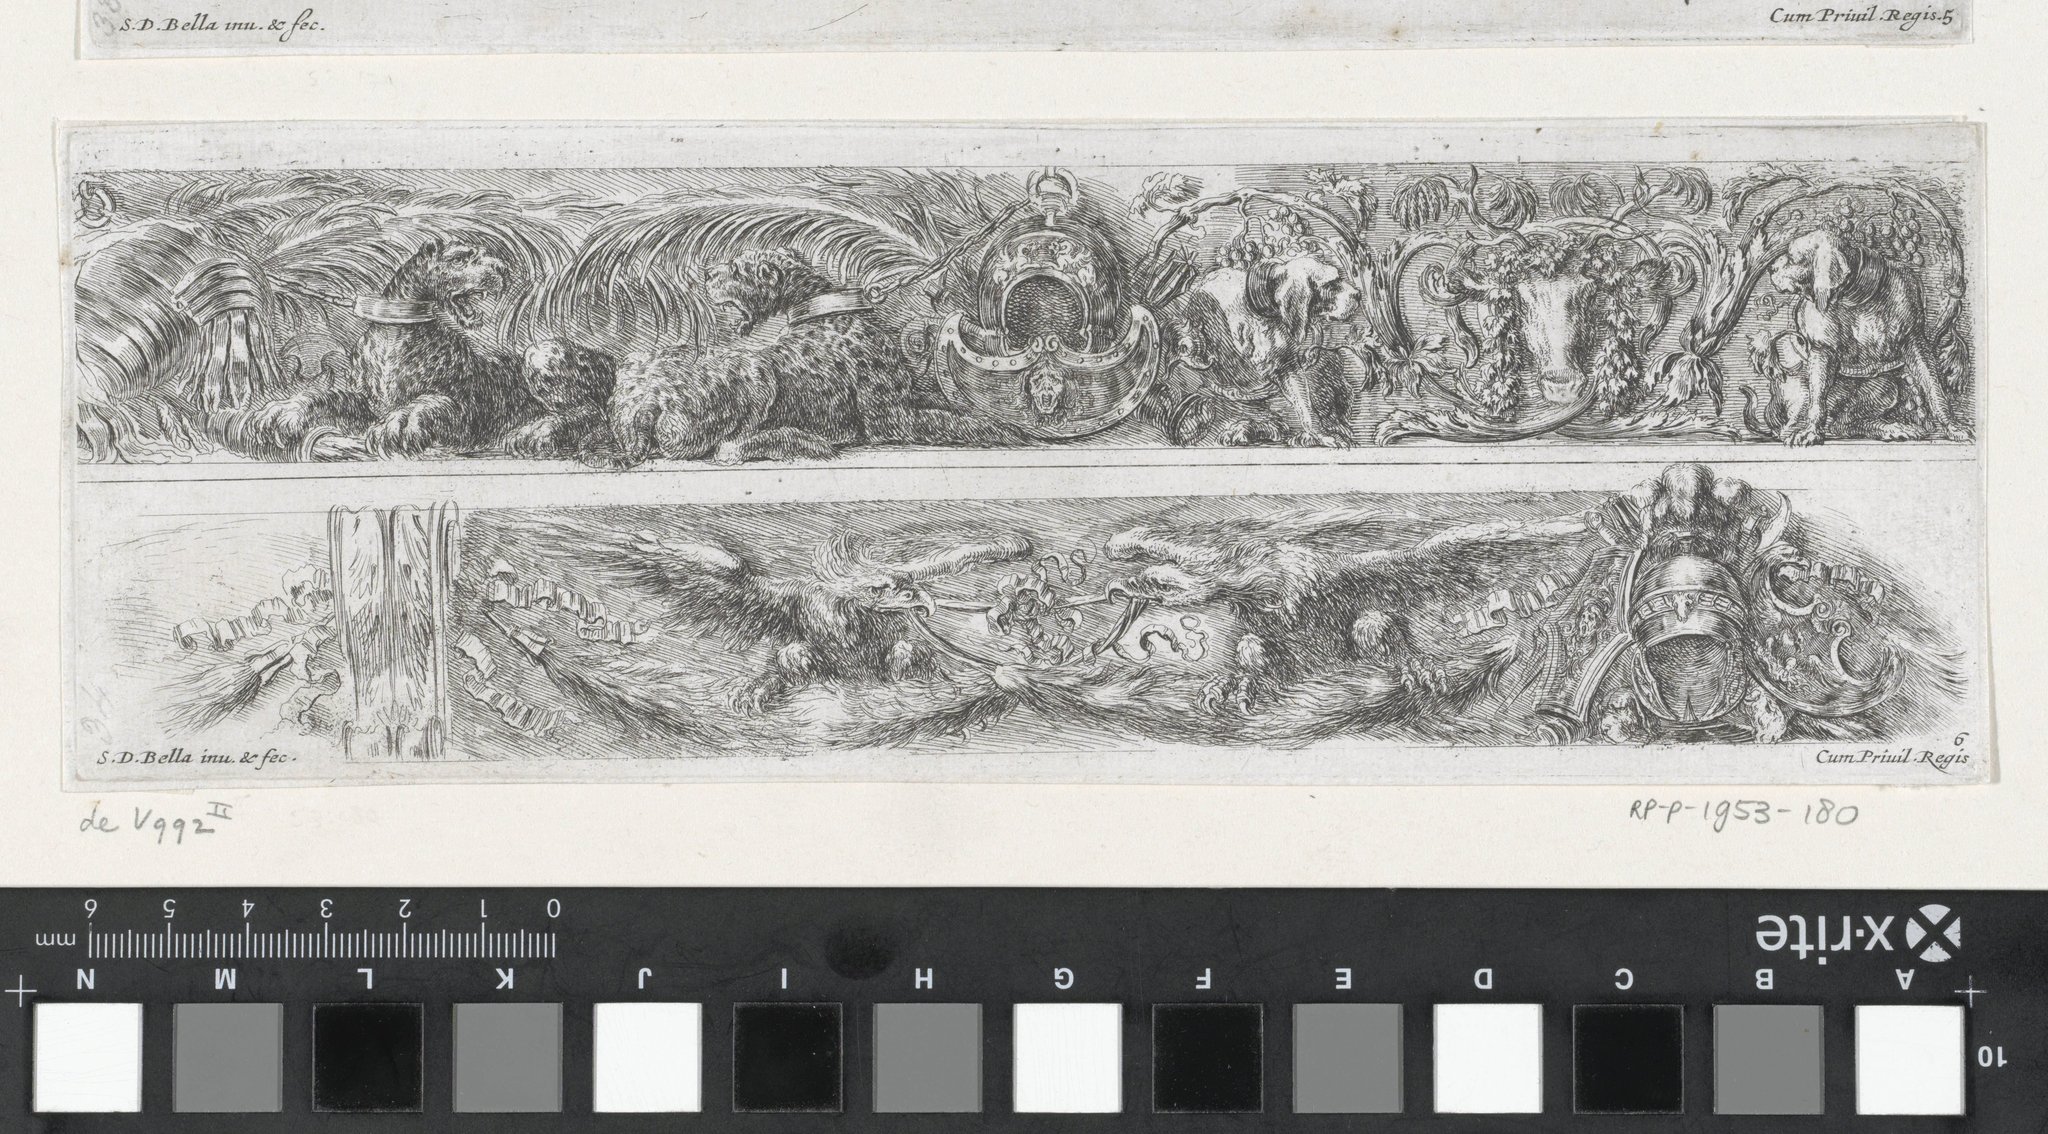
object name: print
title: Twee friezen met panters, honden en adelaars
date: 1620-1664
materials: paper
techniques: etching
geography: france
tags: beasts of prey, predatory animals: panther, predatory birds: eagle (+ ornamental variants of animals), dog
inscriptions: collector's mark: Lugt 2228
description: Twee friezen. Boven: een fries met links twee panters aan kettingen met op de achtergrond palmtakken en rechts een koeienkop met aan weerszijden een hond en bladornament. Onder: een fries met twee adelaars, links twee consoles en rechts wapenrusting.